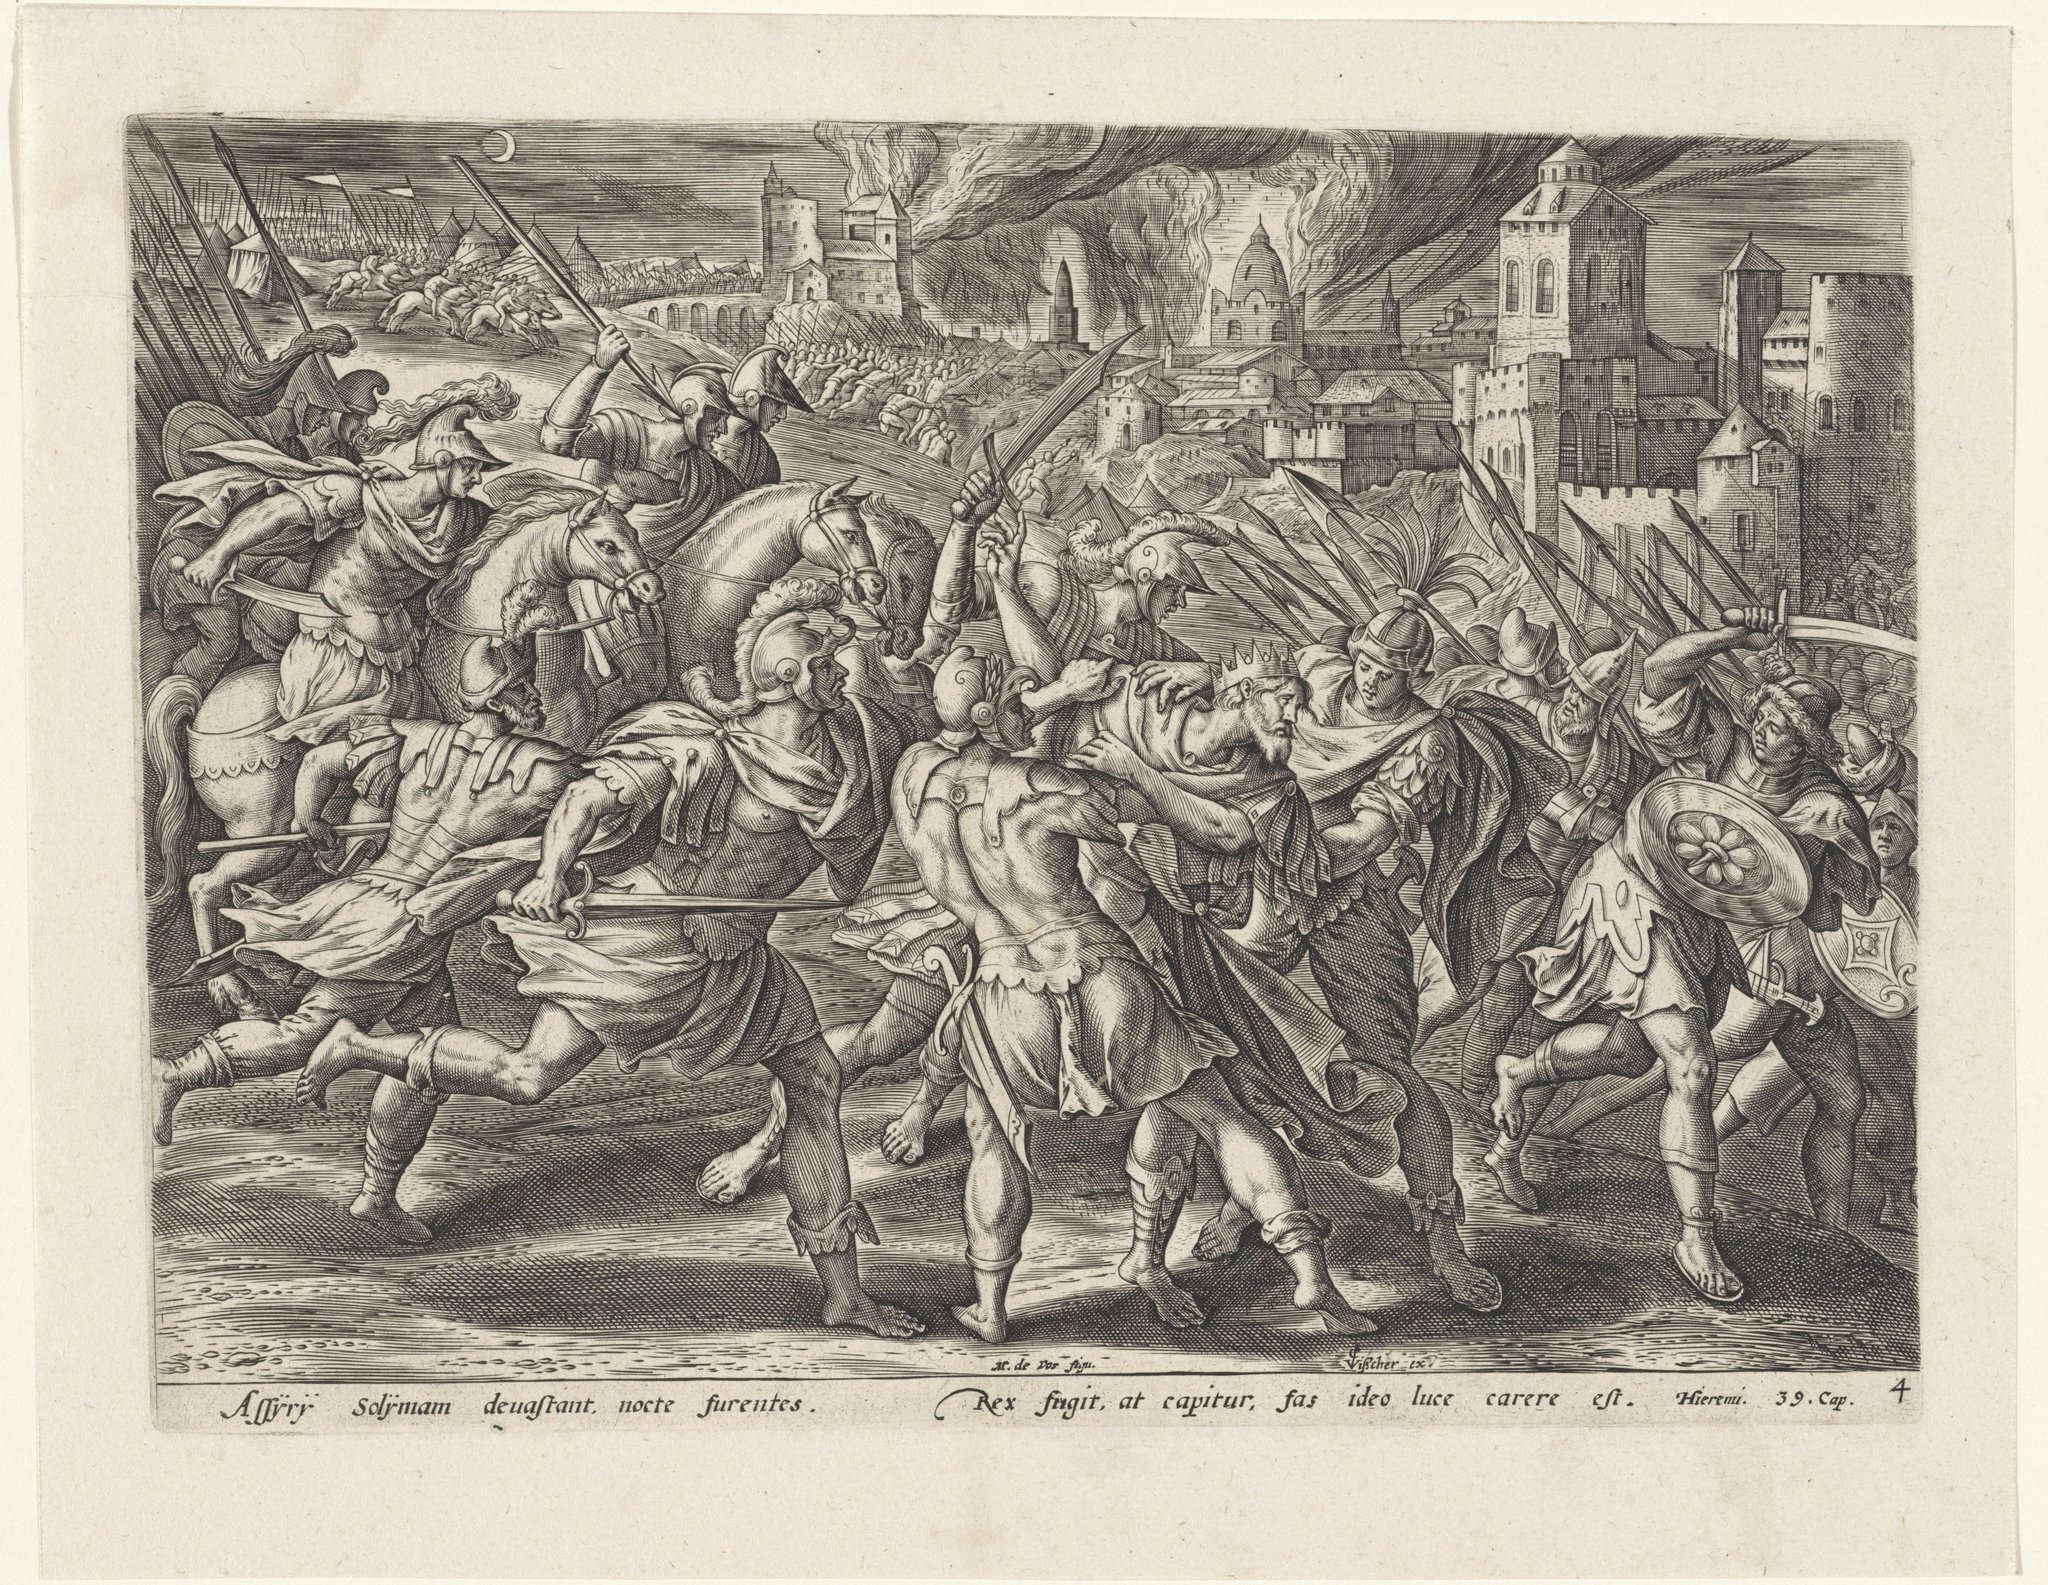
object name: print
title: Gevangenneming van koning Sedekia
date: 1585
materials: paper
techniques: engraving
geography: amsterdam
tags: zedekiah is captured by the babylonians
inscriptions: collector's mark: Lugt 2228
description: Prent gebruikt in: Theatrum biblicum : hoc est historiae sacrae veteris et novi testamenti tabulis aeneis expressae. Opus praesentatissimorum huius ac superioris seculi pictorum atque sculptorum, summo studio conquisitum et in lucem editum. Amsterdam: Claes Jansz. Visscher, 1643.